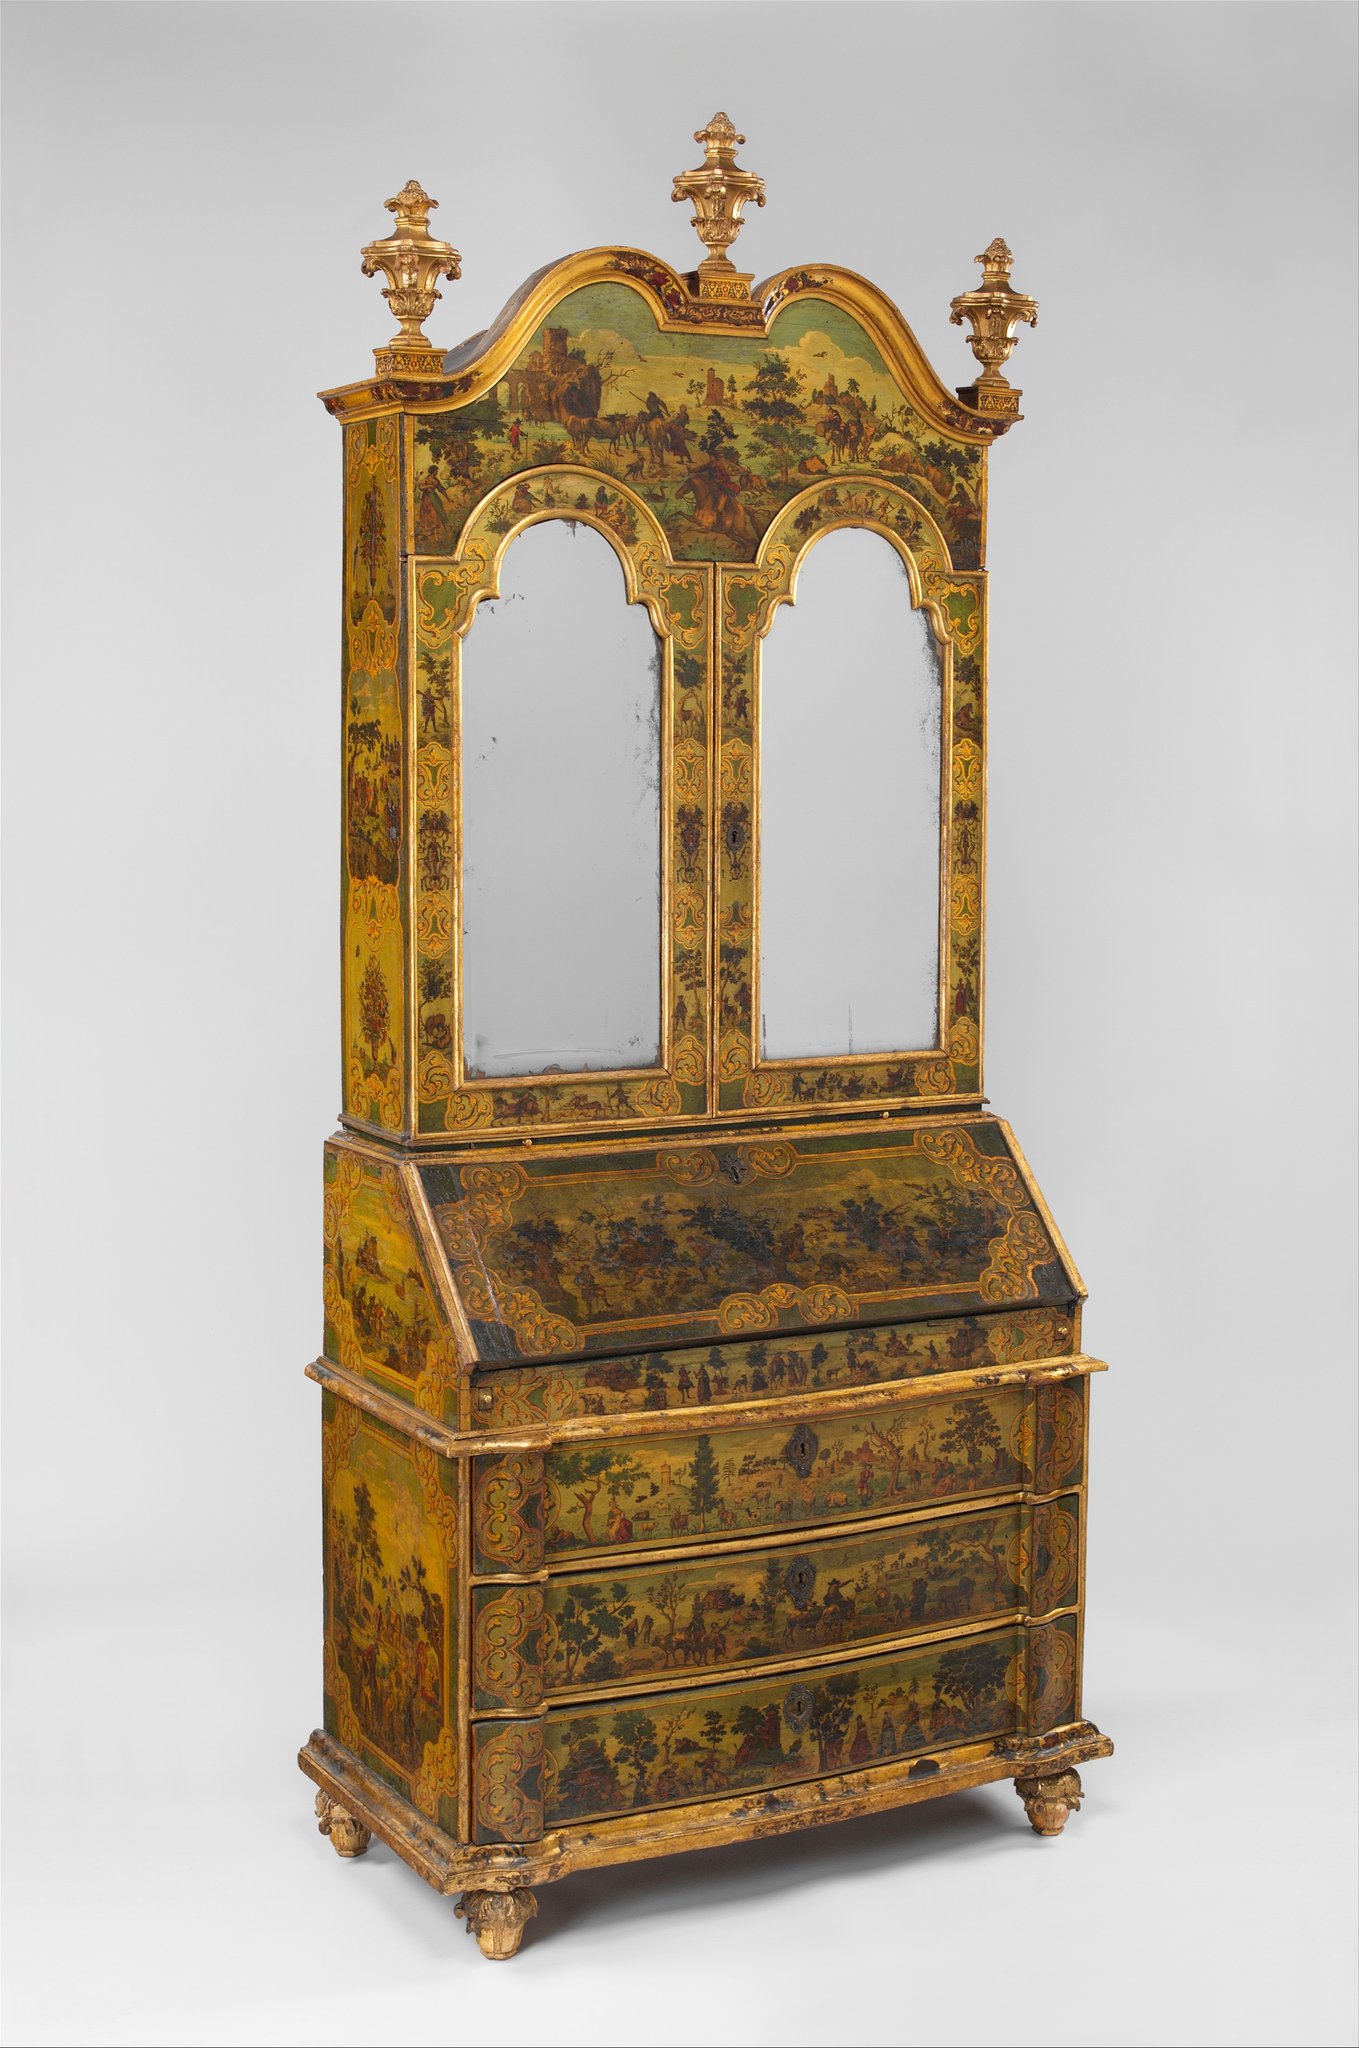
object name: secretary desk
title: Desk (Secretary)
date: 1730-1735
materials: glass, wood, silk, varnish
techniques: carving, gilding, painting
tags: men,women,horses